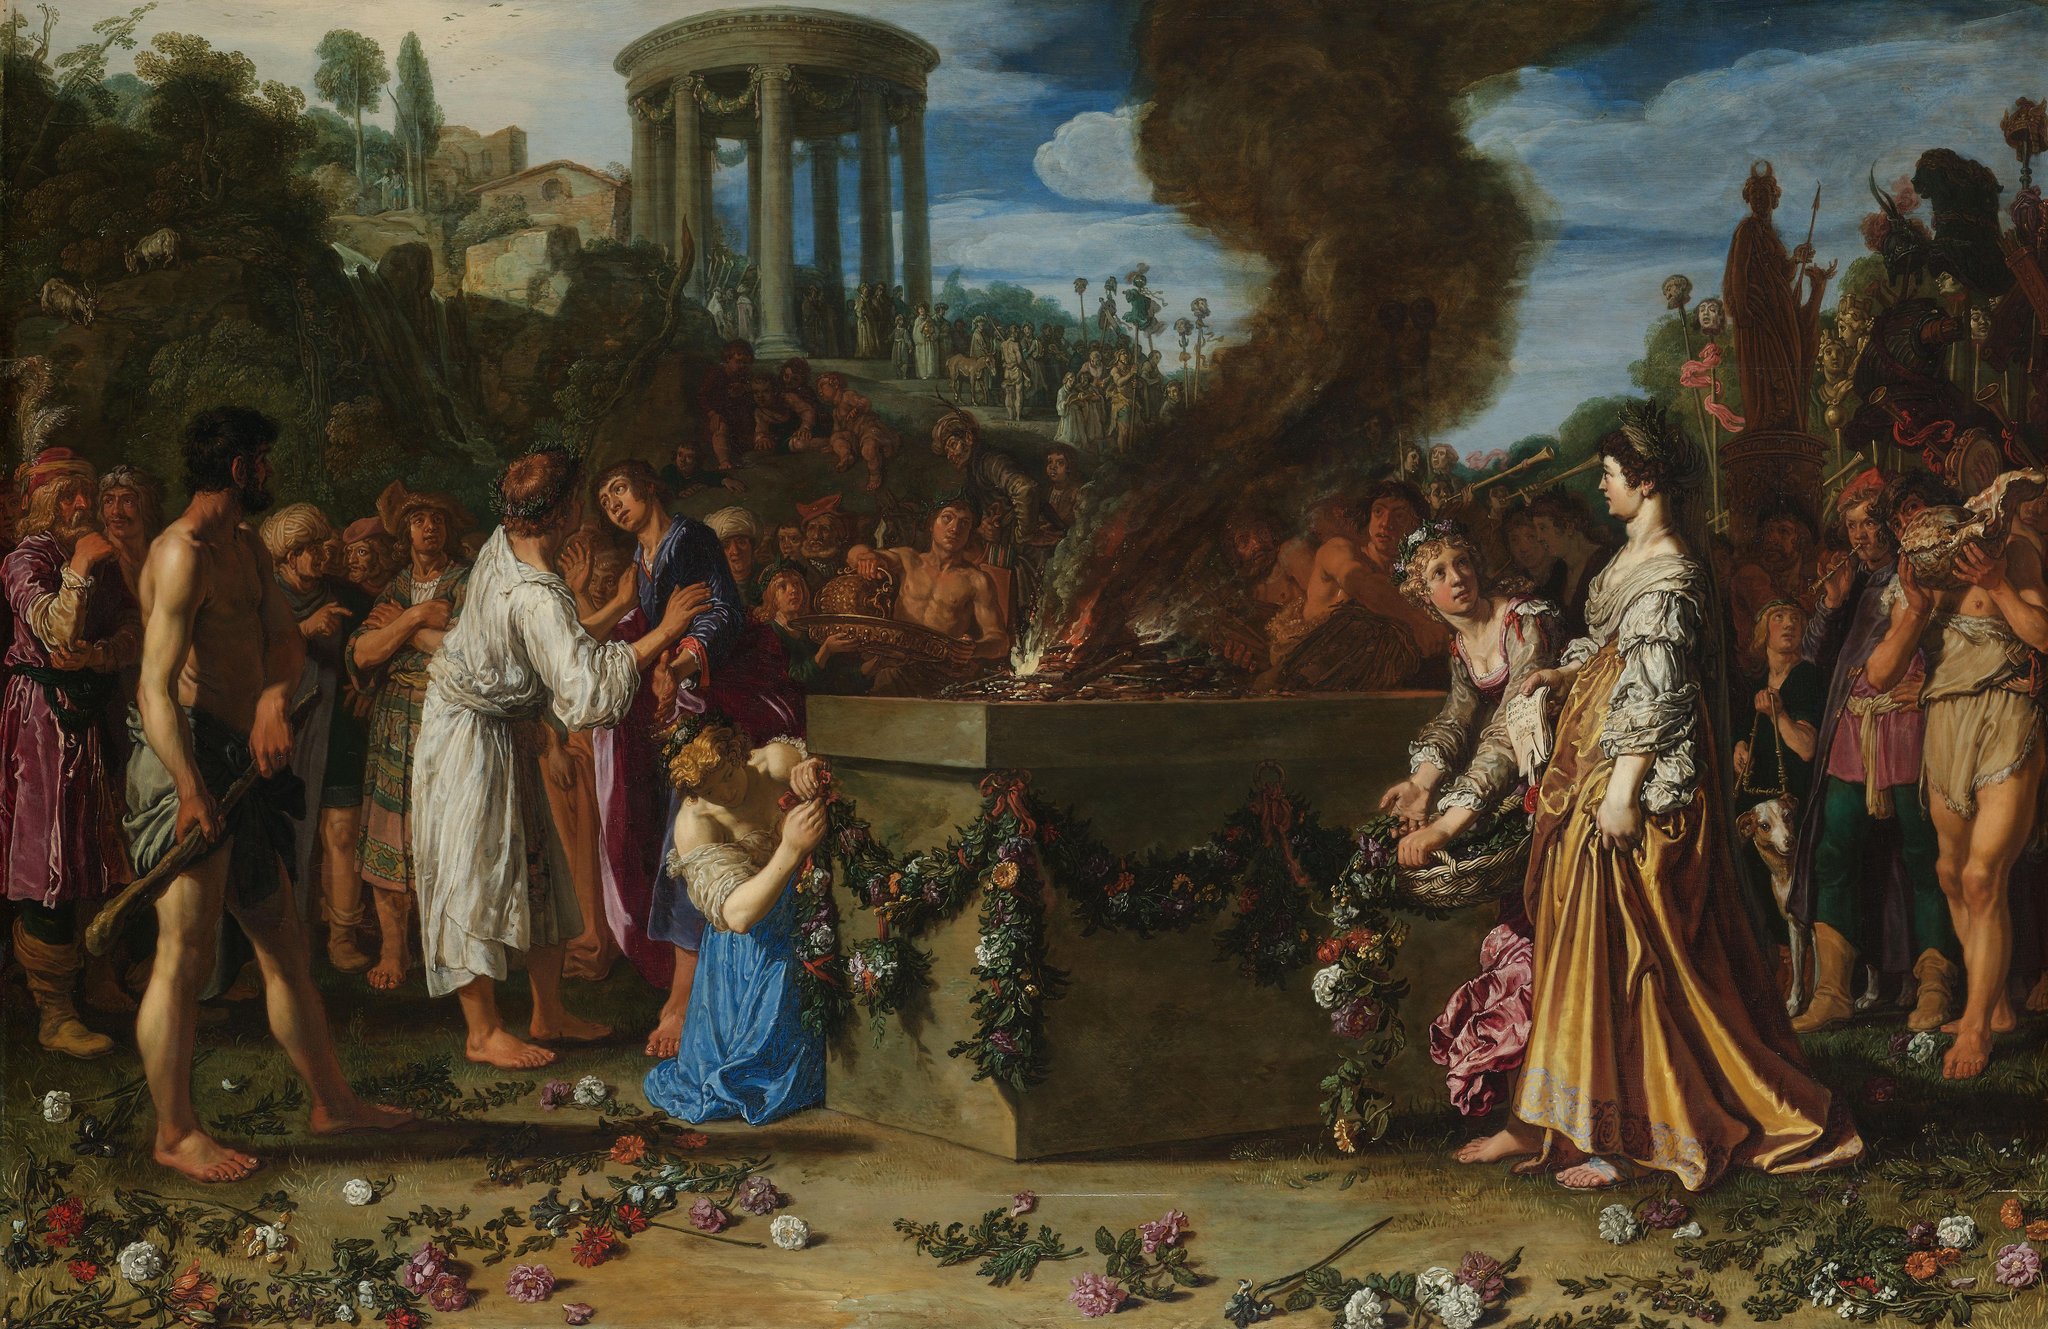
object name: painting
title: Orestes and Pylades Disputing at the Altar (Euripides, Iphigenia in Tauris)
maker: pieter lastman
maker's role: draughtsman, painter, print maker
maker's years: 1583-1633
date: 1614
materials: oil, panel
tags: orestes and pylades argue about who is going to be sacrificed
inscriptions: signature and date, centre, on the altar: ‘Pietro Lastman fecit 1614’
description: This painting depicts a story from Greek antiquity. Orestes and Pylades (left) were caught trying to steal a statue of Diana from the temple (left background). One of them will have to die. At the altar, the friends argue over who will give his life for the other. Lastman’s densely composed compositions, his bright colours and the expressive gestures of his figures – all had an impact on the young Rembrandt.